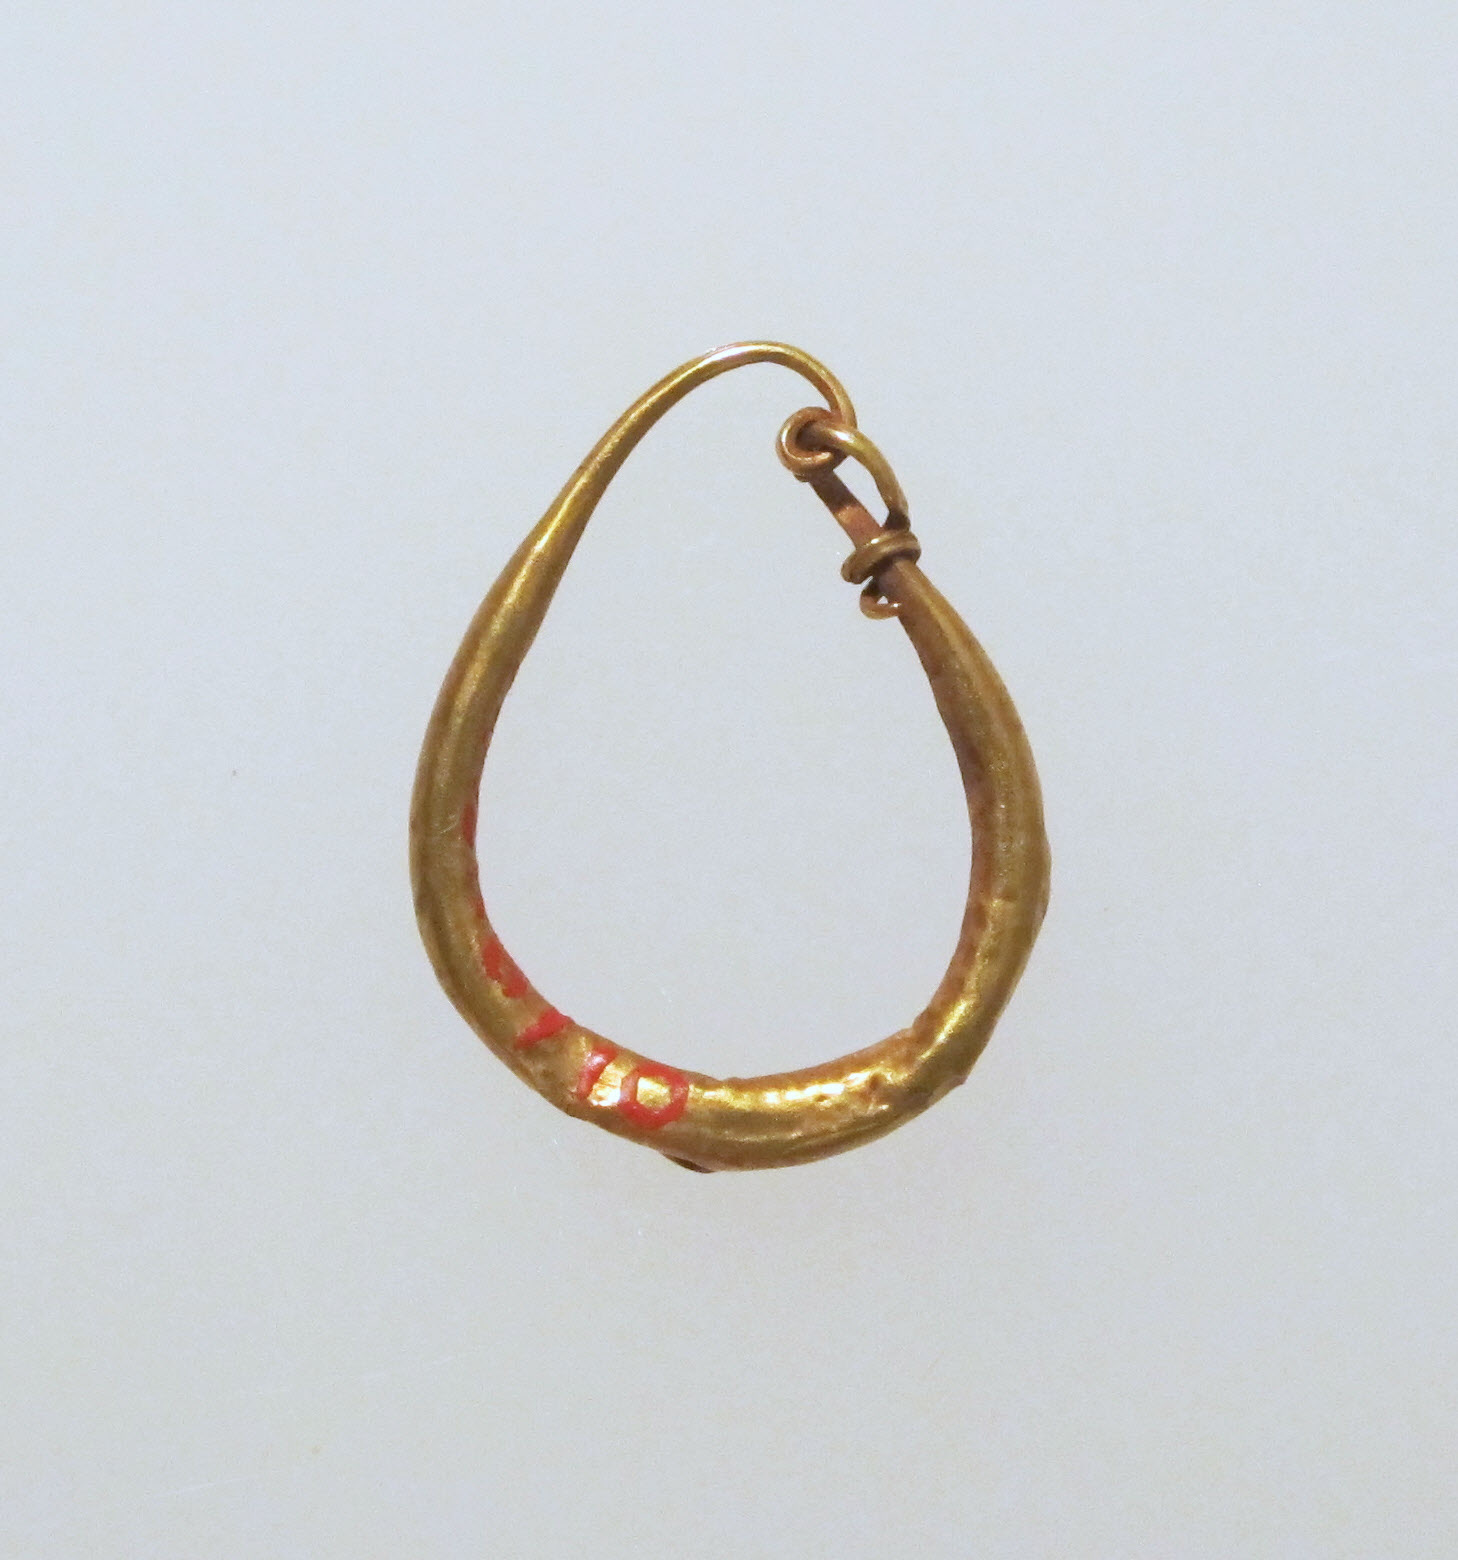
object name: earring loop type, plain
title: Earring-loop type, plain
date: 7000 BCE-330 CE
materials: gold